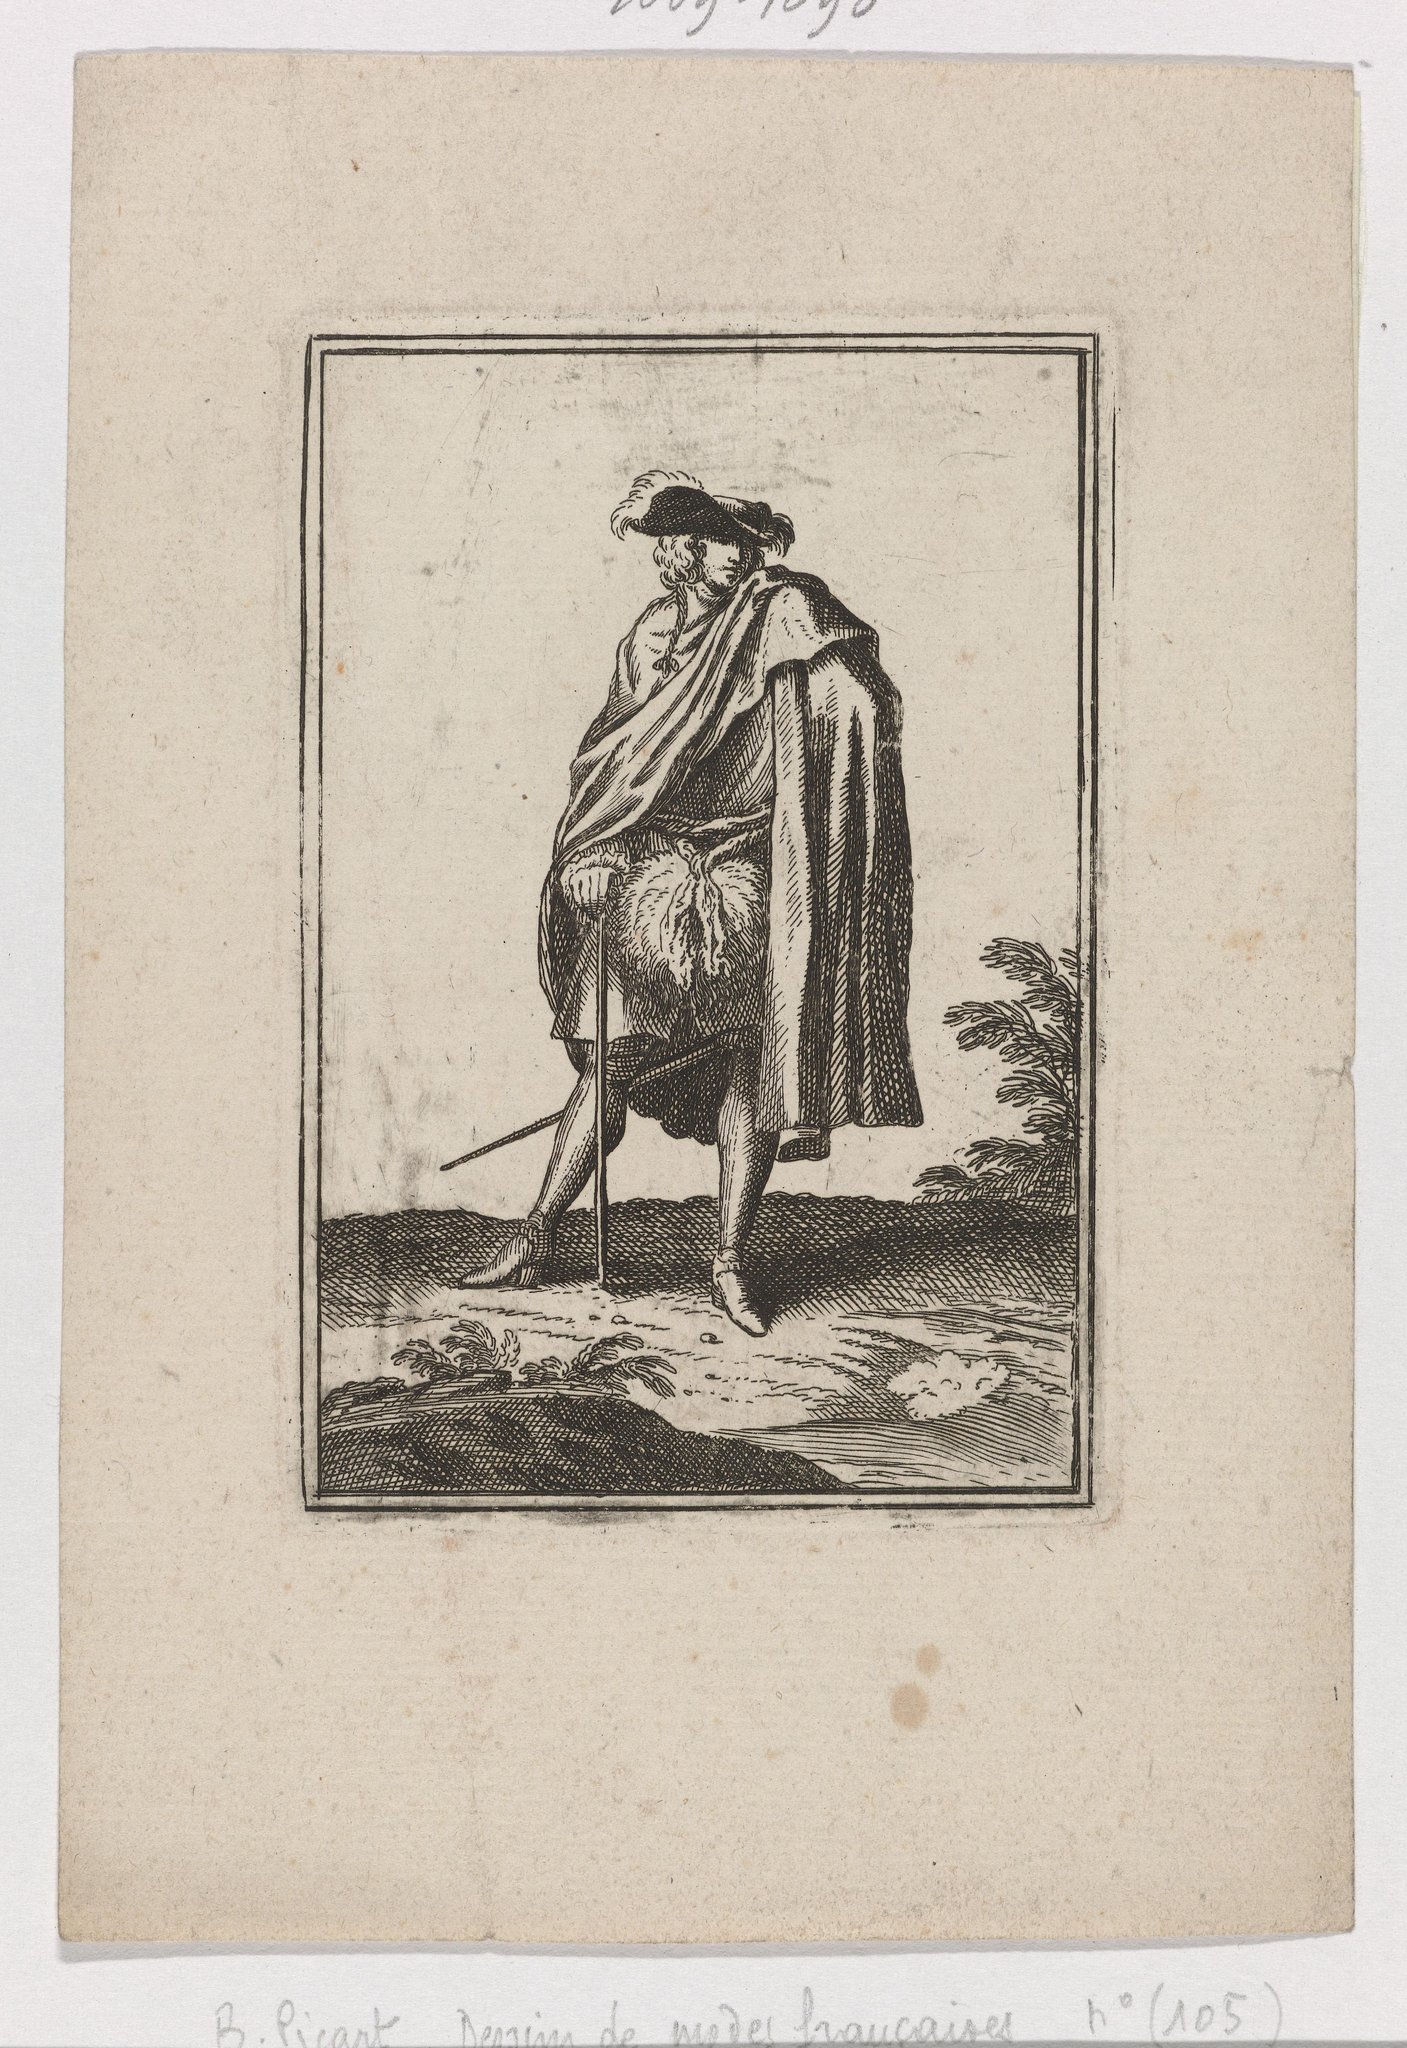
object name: print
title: Heer met grote mof, degen en wandelstok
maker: bernard picart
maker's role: draughtsman, print maker, publisher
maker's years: 1673-1733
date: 1706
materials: paper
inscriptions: date